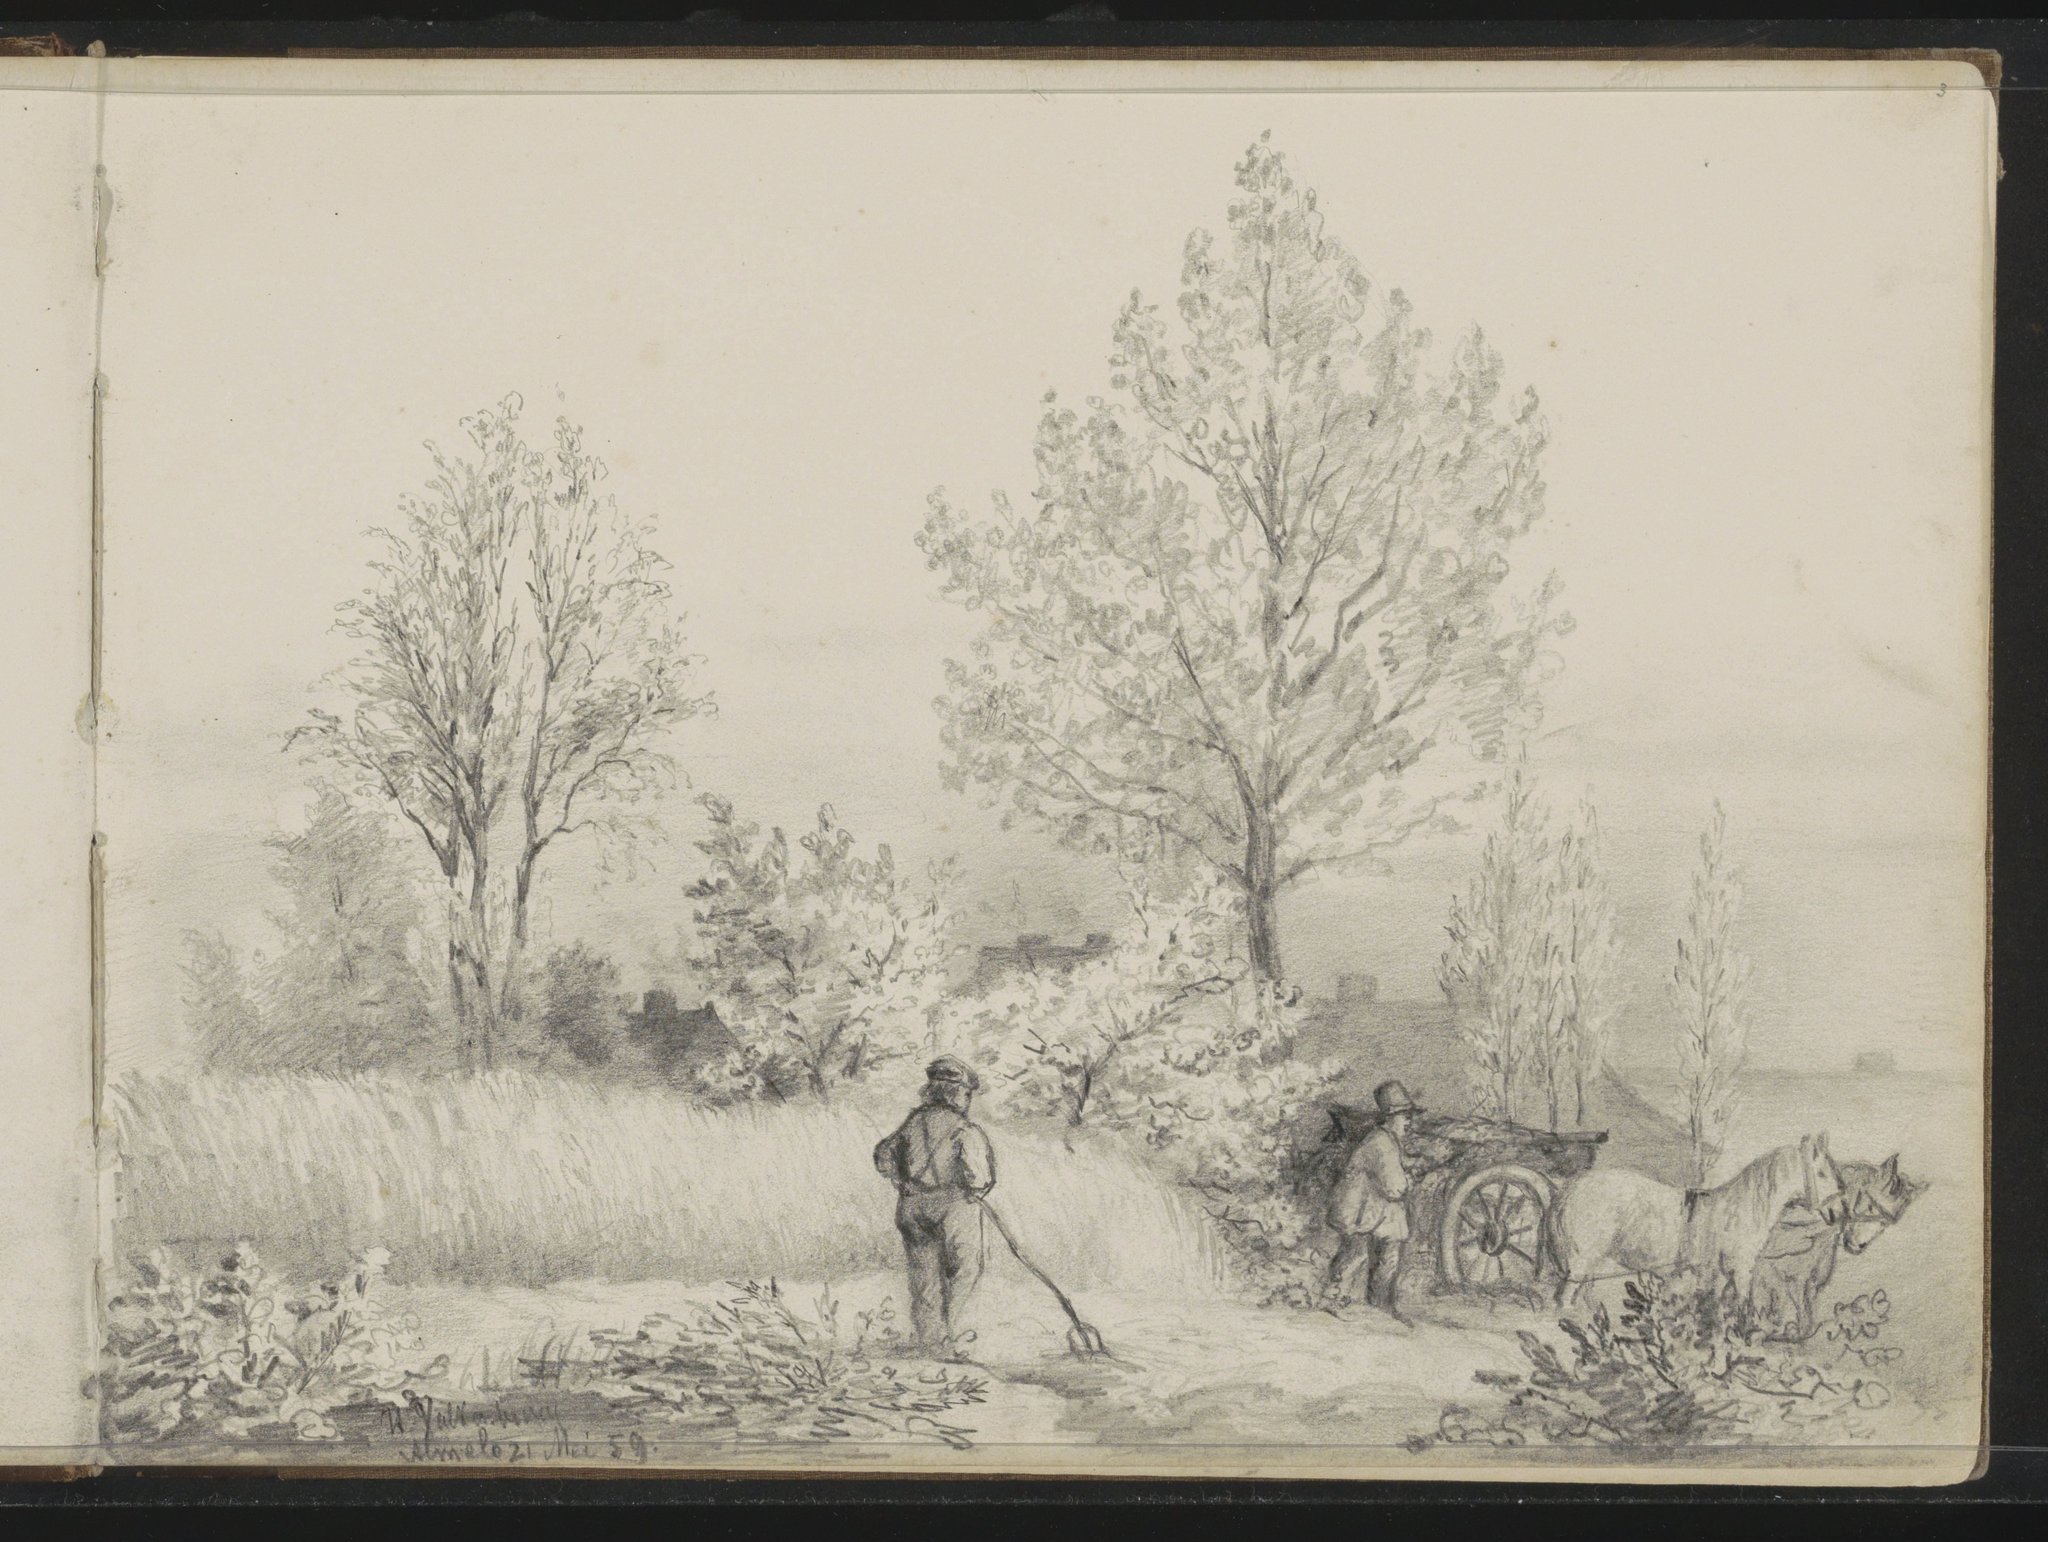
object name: sketchbook leaf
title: Landschap met twee boeren te Almelo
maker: hendrik valkenburg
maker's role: draughtsman, painter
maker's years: 1826-1896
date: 1805-1859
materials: paper, pencil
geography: almelo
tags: animal traction, animal-drawn vehicle (carriage etc.), farmers, landscapes (+ landscape with figures, staffage)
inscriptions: signature: ‘H. Valkenburg’, date and inscription: ‘Almelo 21 Mei 59.’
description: Eén van de boeren leunt op een riek. De ander staat bij een kar waarvoor twee paarden zijn gespannen. Op de achtergrond bomen en de daken van huizen. Blad 3 recto uit een schetsboek met 77 bladen.